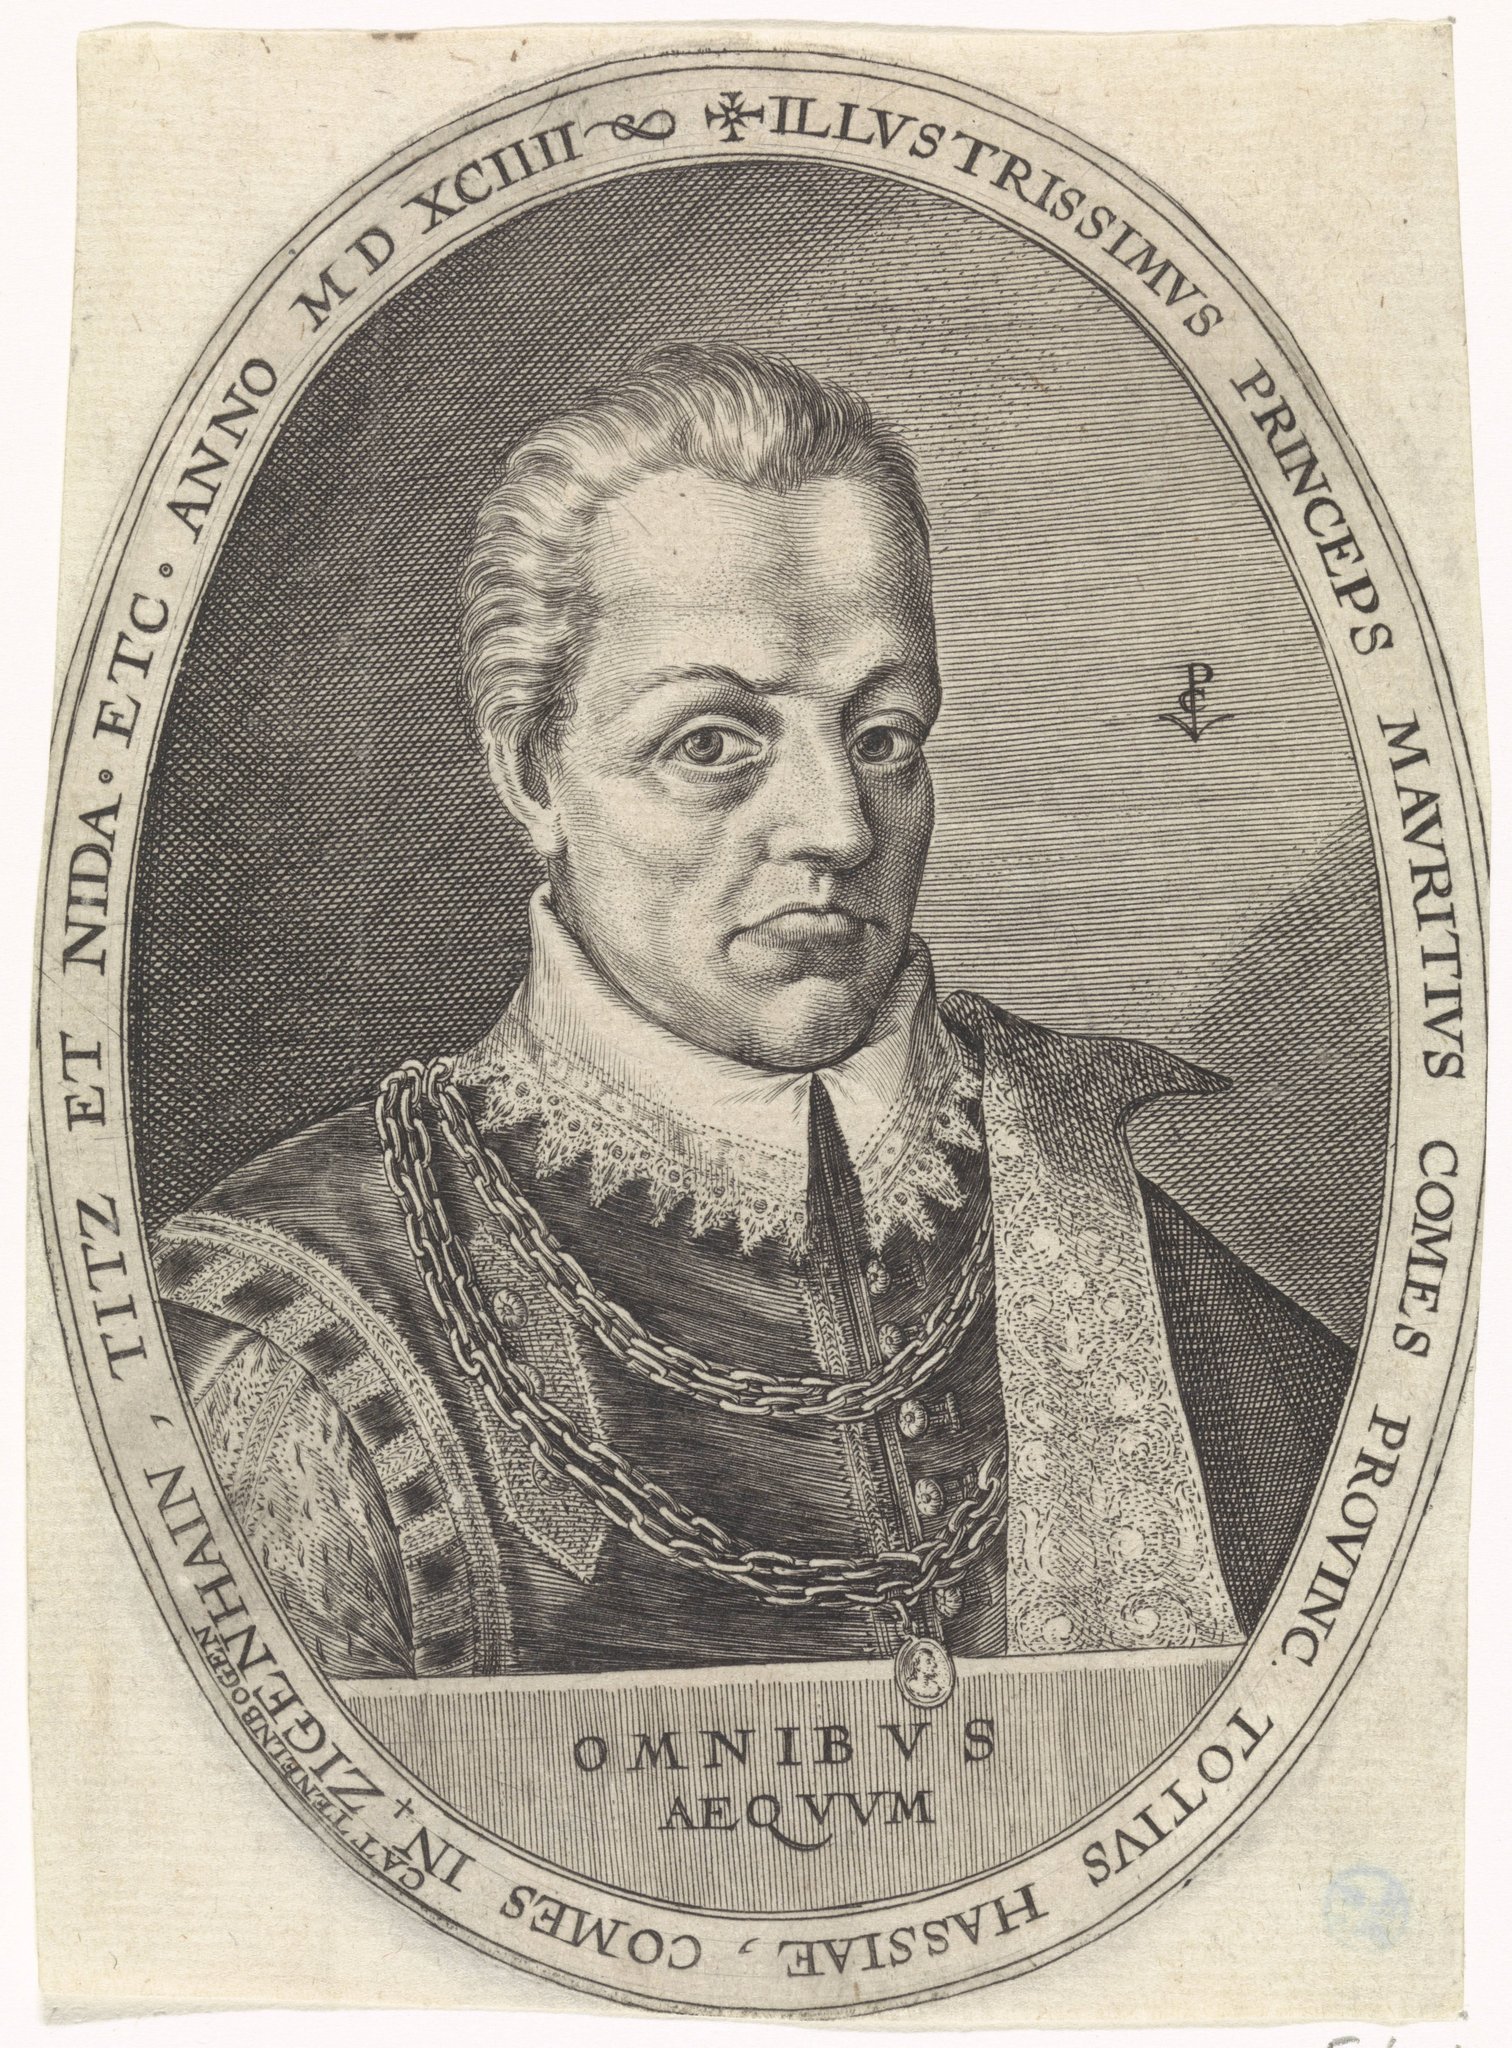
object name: print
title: Portret van Maurits van Hessen-Kassel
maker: crispijn van de passe (i)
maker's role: draughtsman, print maker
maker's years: 1564-1637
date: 1594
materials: paper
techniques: engraving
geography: cologne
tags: sleeves, historical persons, neck-gear: collar, necklace (+ men's clothes)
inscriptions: collector's mark: Lugt 2228, collector's mark: Lugt 1337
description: Portret van de landgraaf Maurits van Hessen-Kassel, eronder zijn devies in het Latijn. In het randschrift van de omlijsting de naam en functie van de geportretteerde in het Latijn.